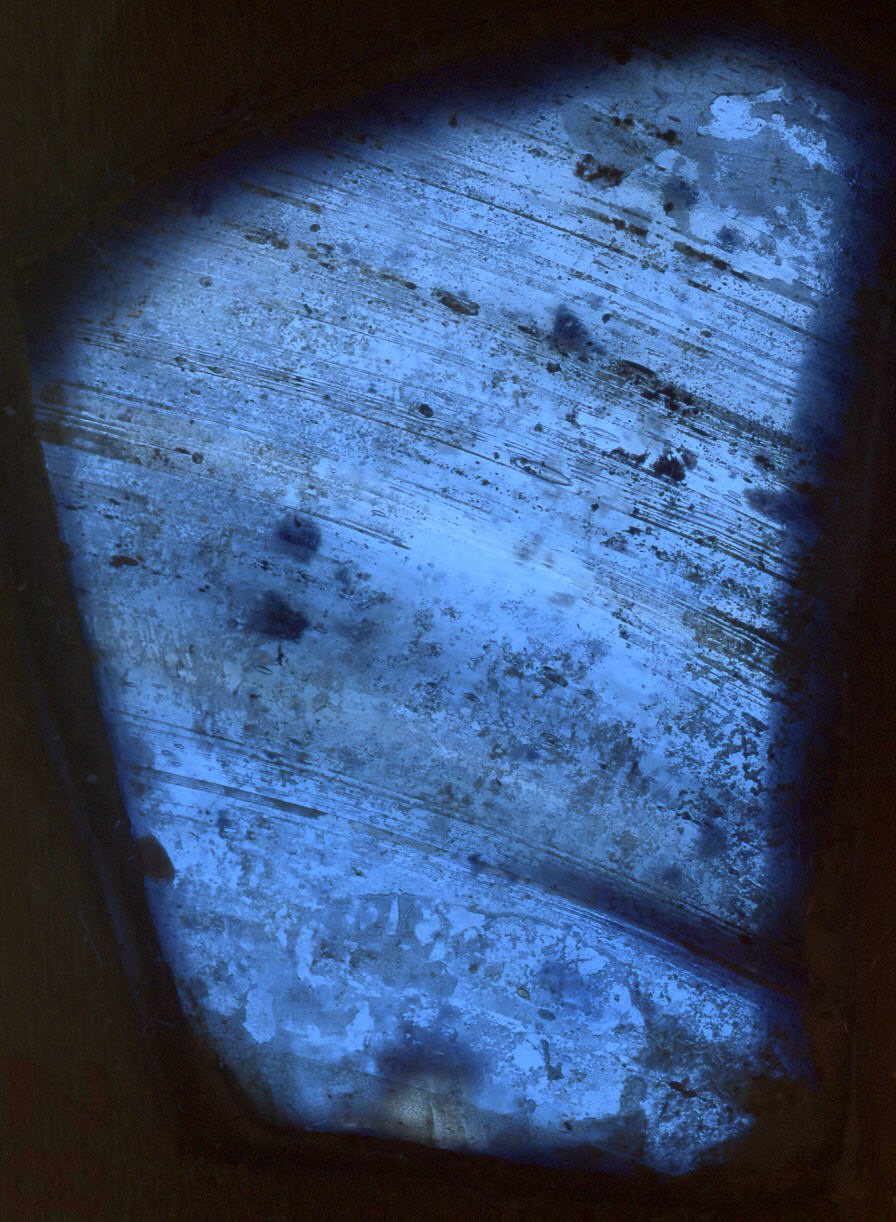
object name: fragment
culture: crusader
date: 1201-1300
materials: glass